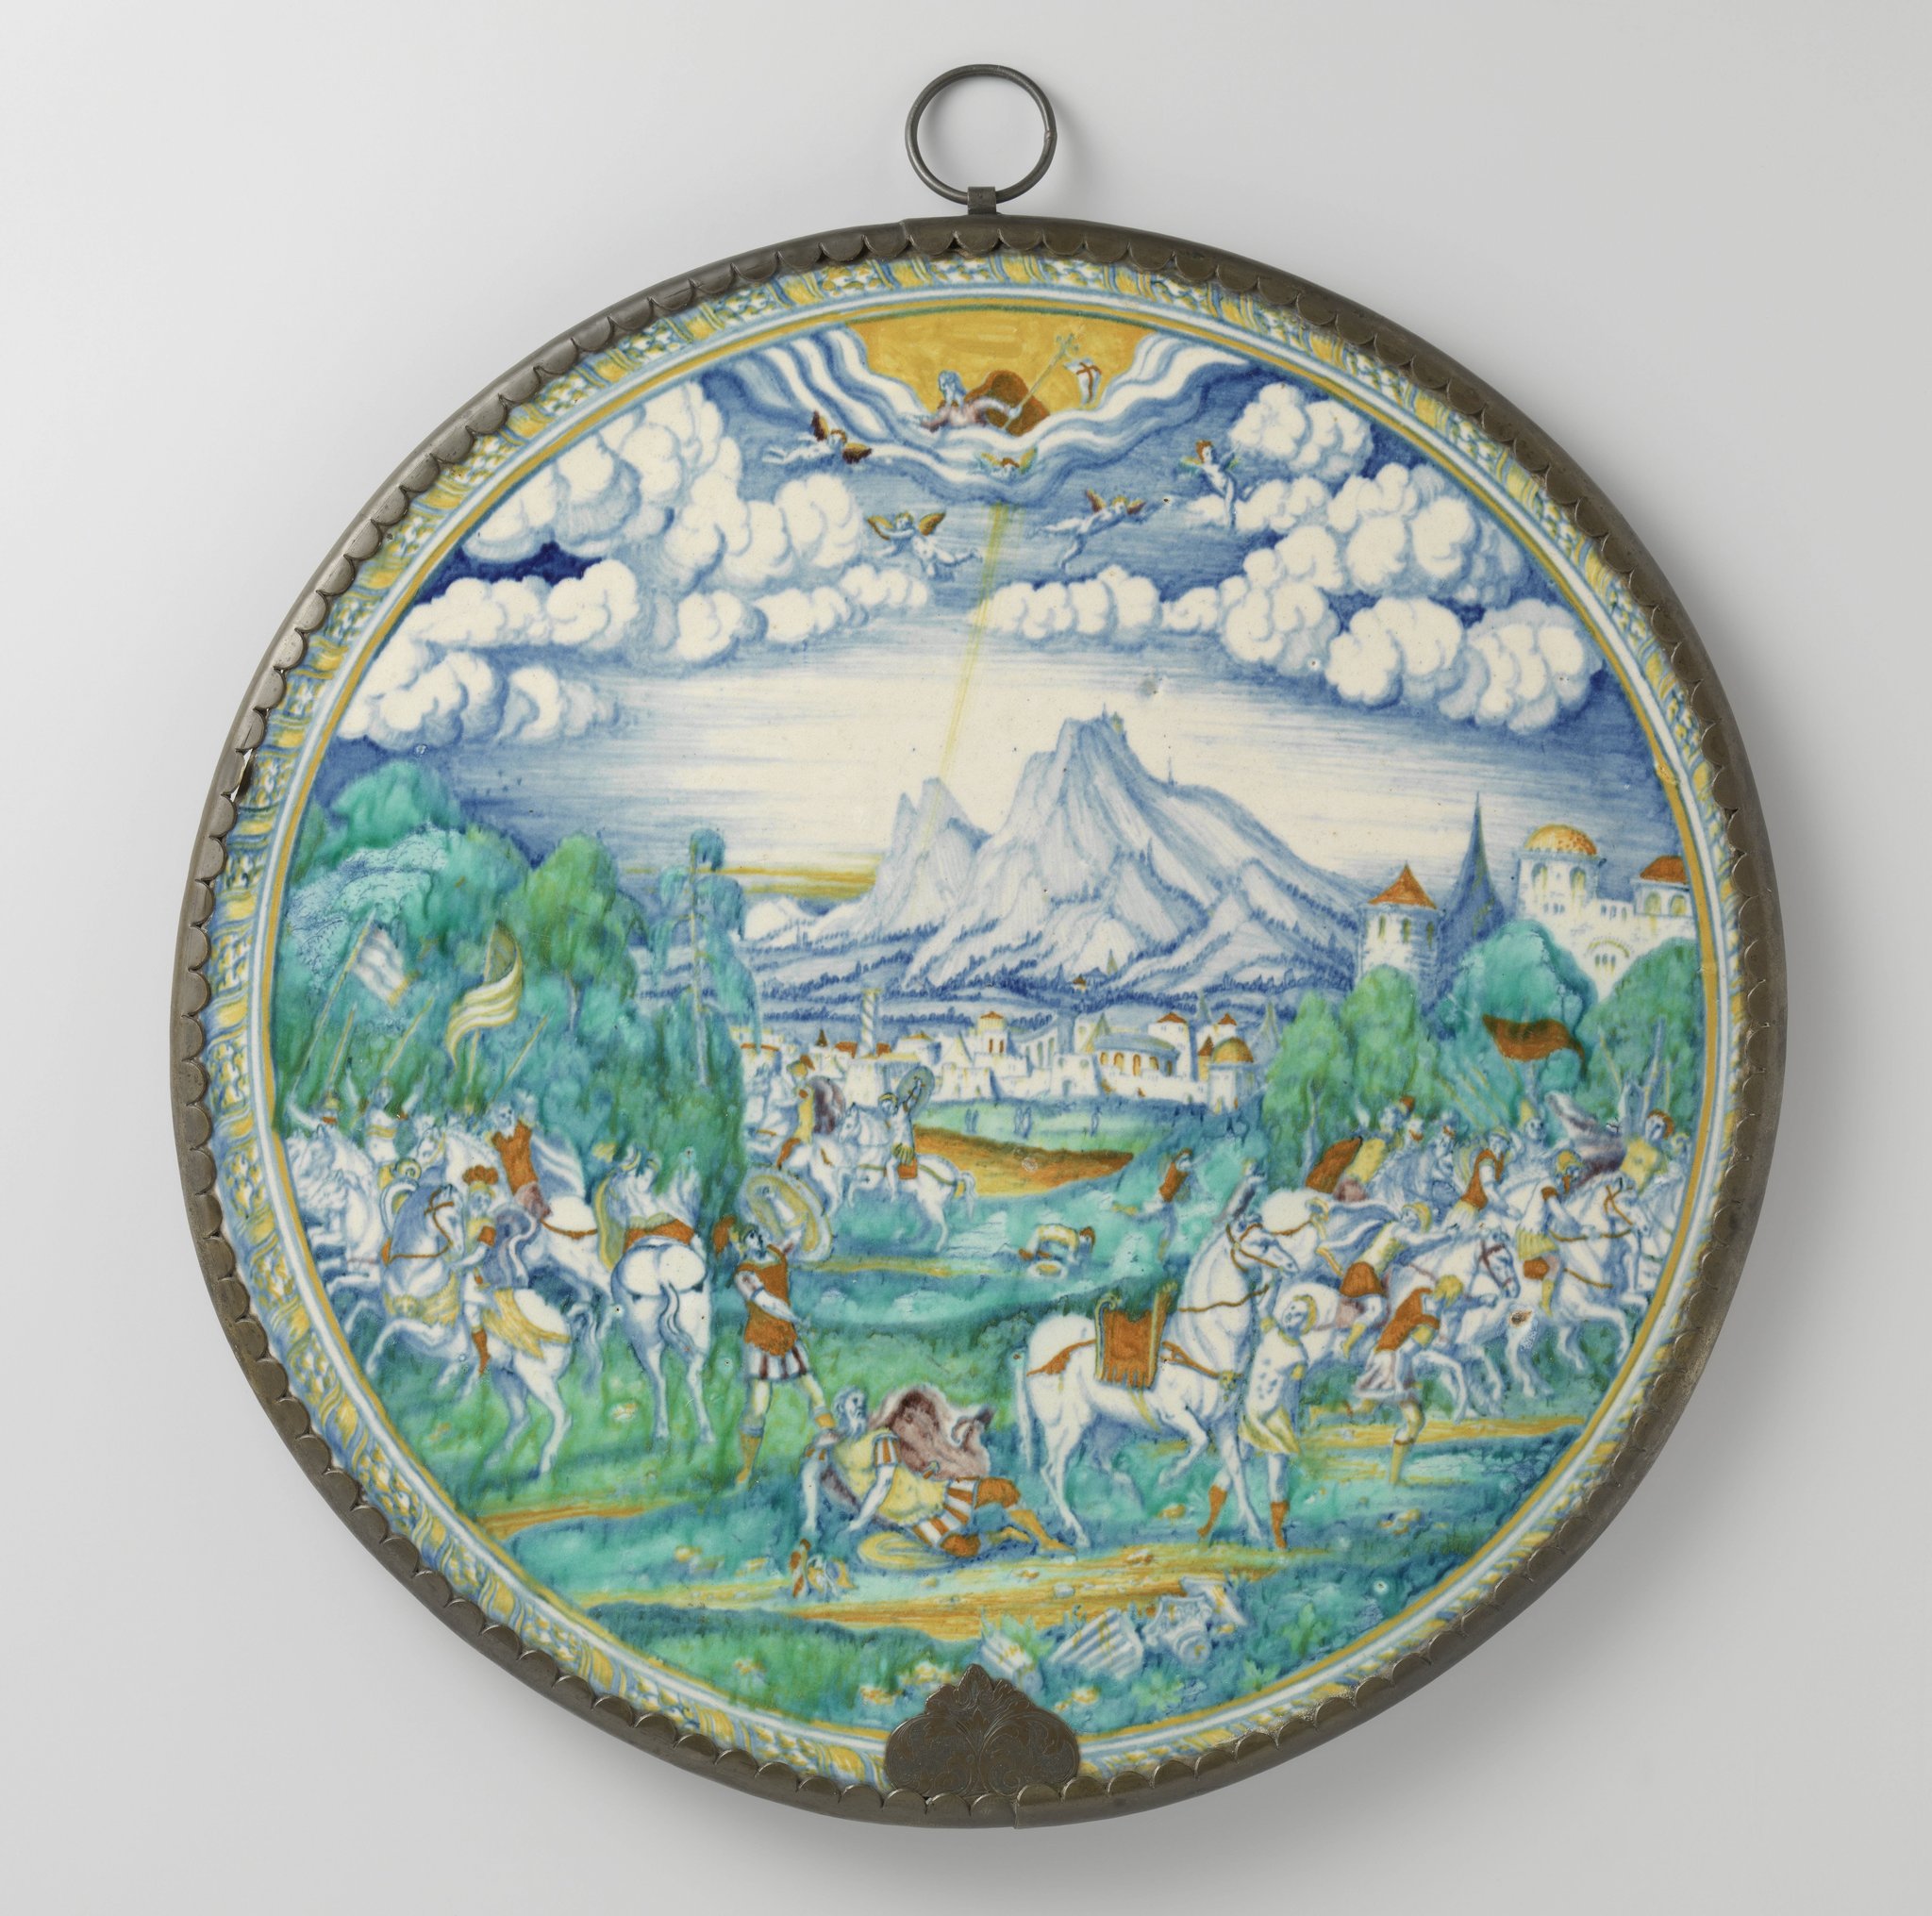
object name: platter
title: Charger with the Conversion of Saul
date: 1550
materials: earthenware, glaze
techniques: maiolica, painted, polychromy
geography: antwerp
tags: on the way to damascus christ appears to saul, who falls from his horse and is blinded by the light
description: This Antwerp charger would originally have been some 50 cm in diameter. When the rim around the central scene was damaged, it was removed and replaced by a brass mount. Such a dish would never have been used for eating, but would have been displayed on a wall as a painting in ceramic. The absence of the rim now reinforces the dish’s resemblance to a painting.